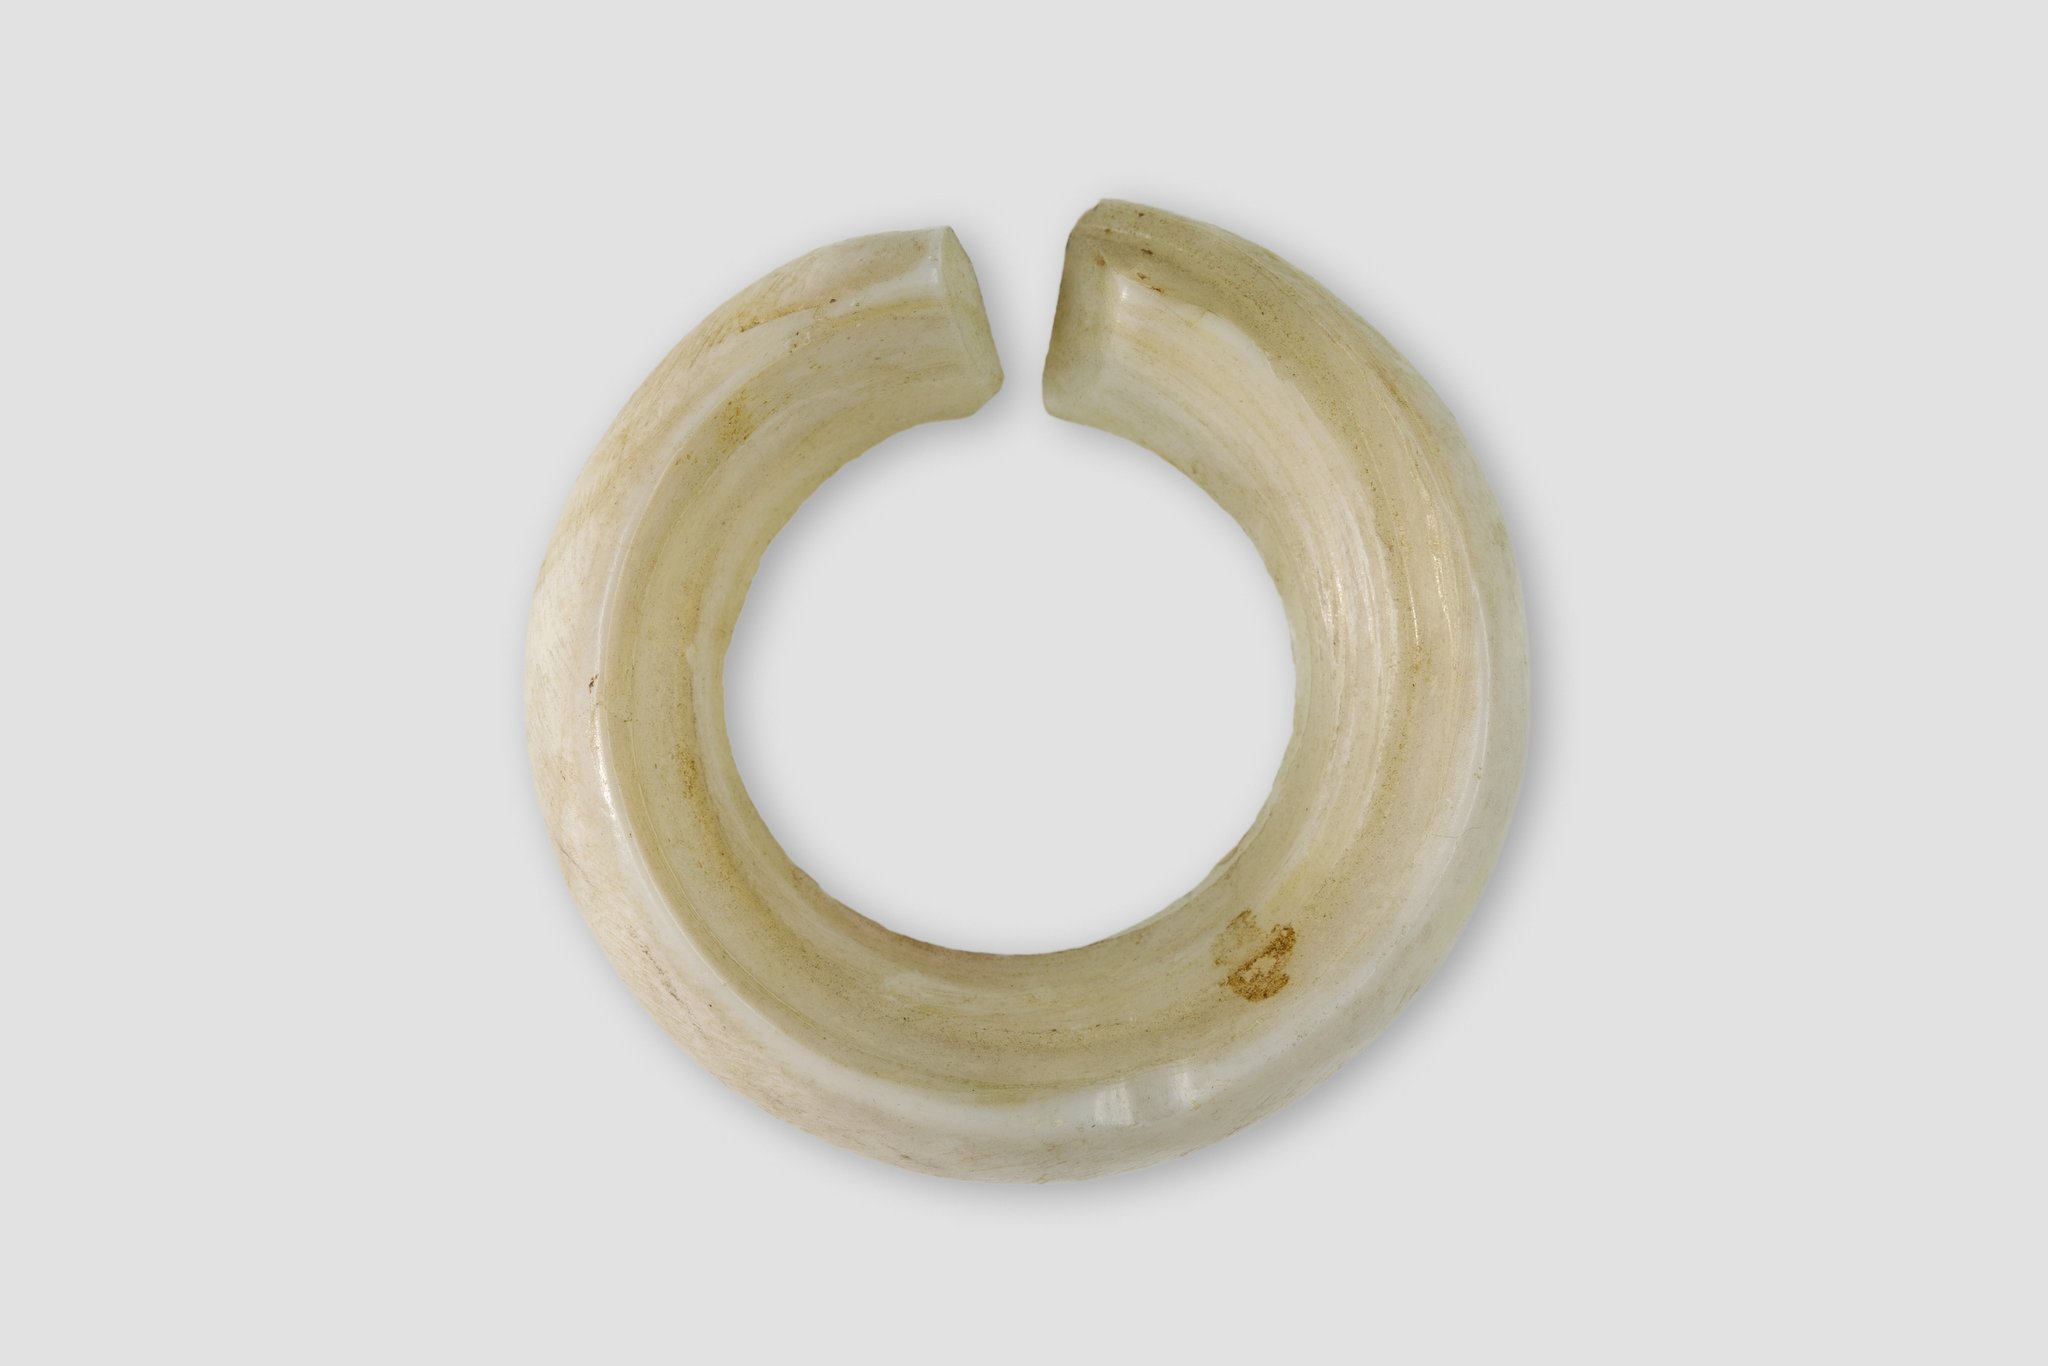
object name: earring, penannular, circular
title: Penannular Earring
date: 1550-1295 BCE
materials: shell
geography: northern upper egypt